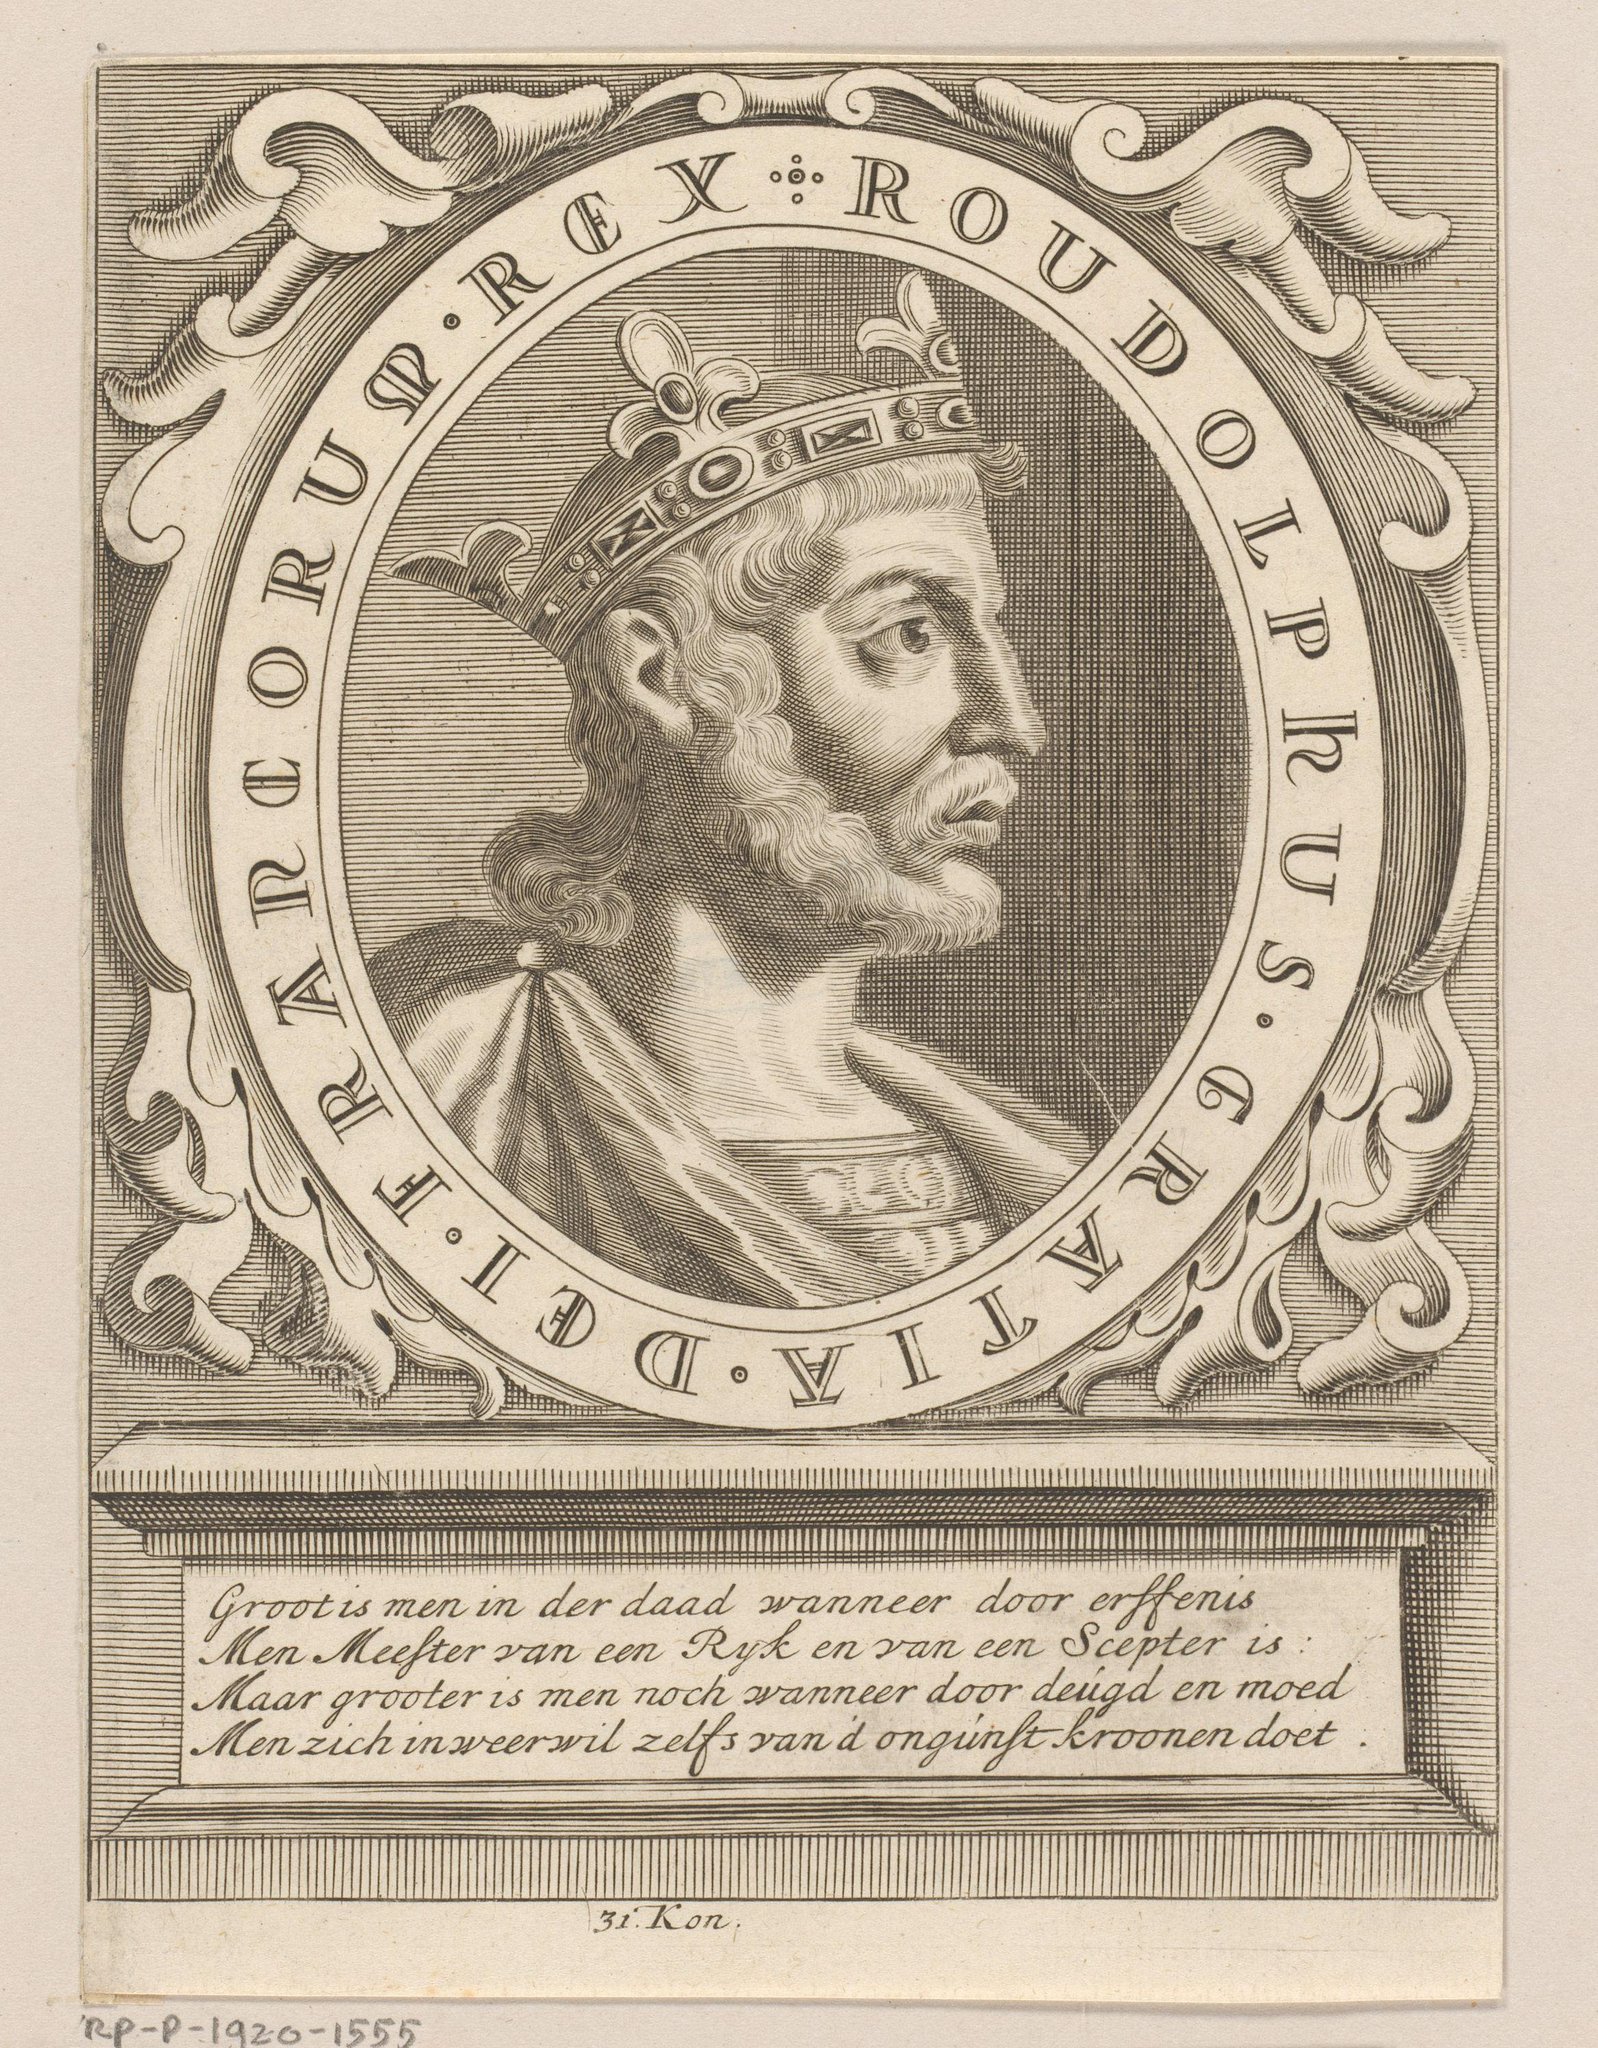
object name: print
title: Roudolphus gratia dei Francorum rex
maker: Anonymous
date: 1685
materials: paper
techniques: engraving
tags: historical persons, king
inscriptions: collector's mark: Lugt 2228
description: Prent gebruikt in: Eudes de Mézeray, François. Chronyk van Vrankryk. 6 dln. Amsterdam: Jan Bouman en Timotheum ten Hoorn, 1685, dl. 1.